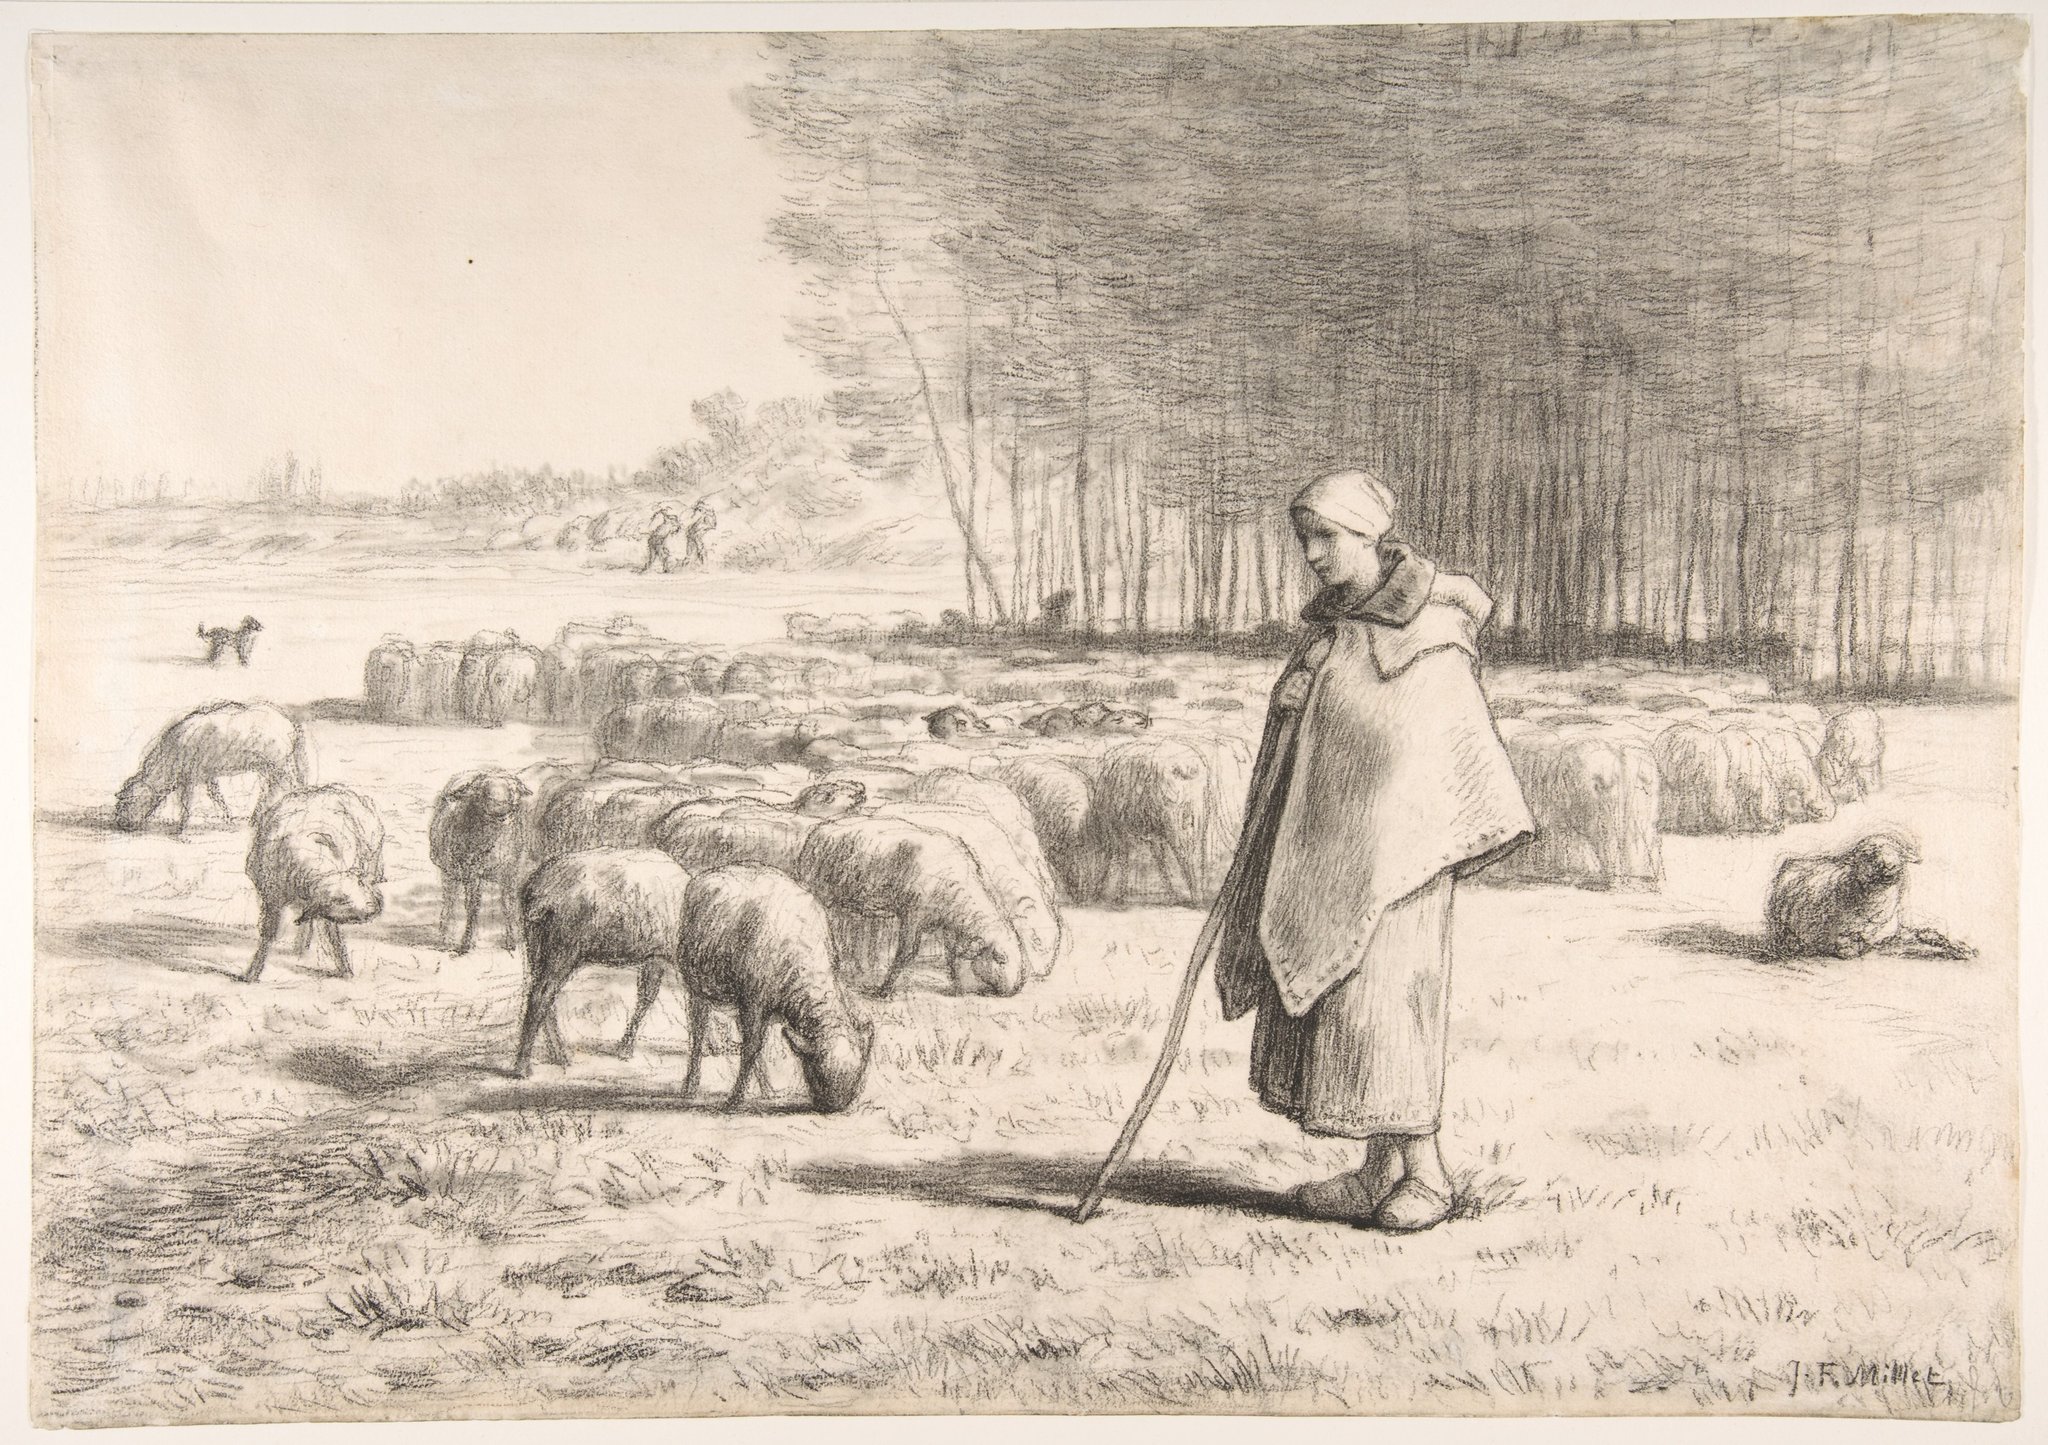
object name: drawing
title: A Shepherdess with Her Flock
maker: jean-françois millet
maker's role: artist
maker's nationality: french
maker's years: 1814-1875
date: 1852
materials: crayon, paper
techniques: stumping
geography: france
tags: men,sheep,trees,shepherds